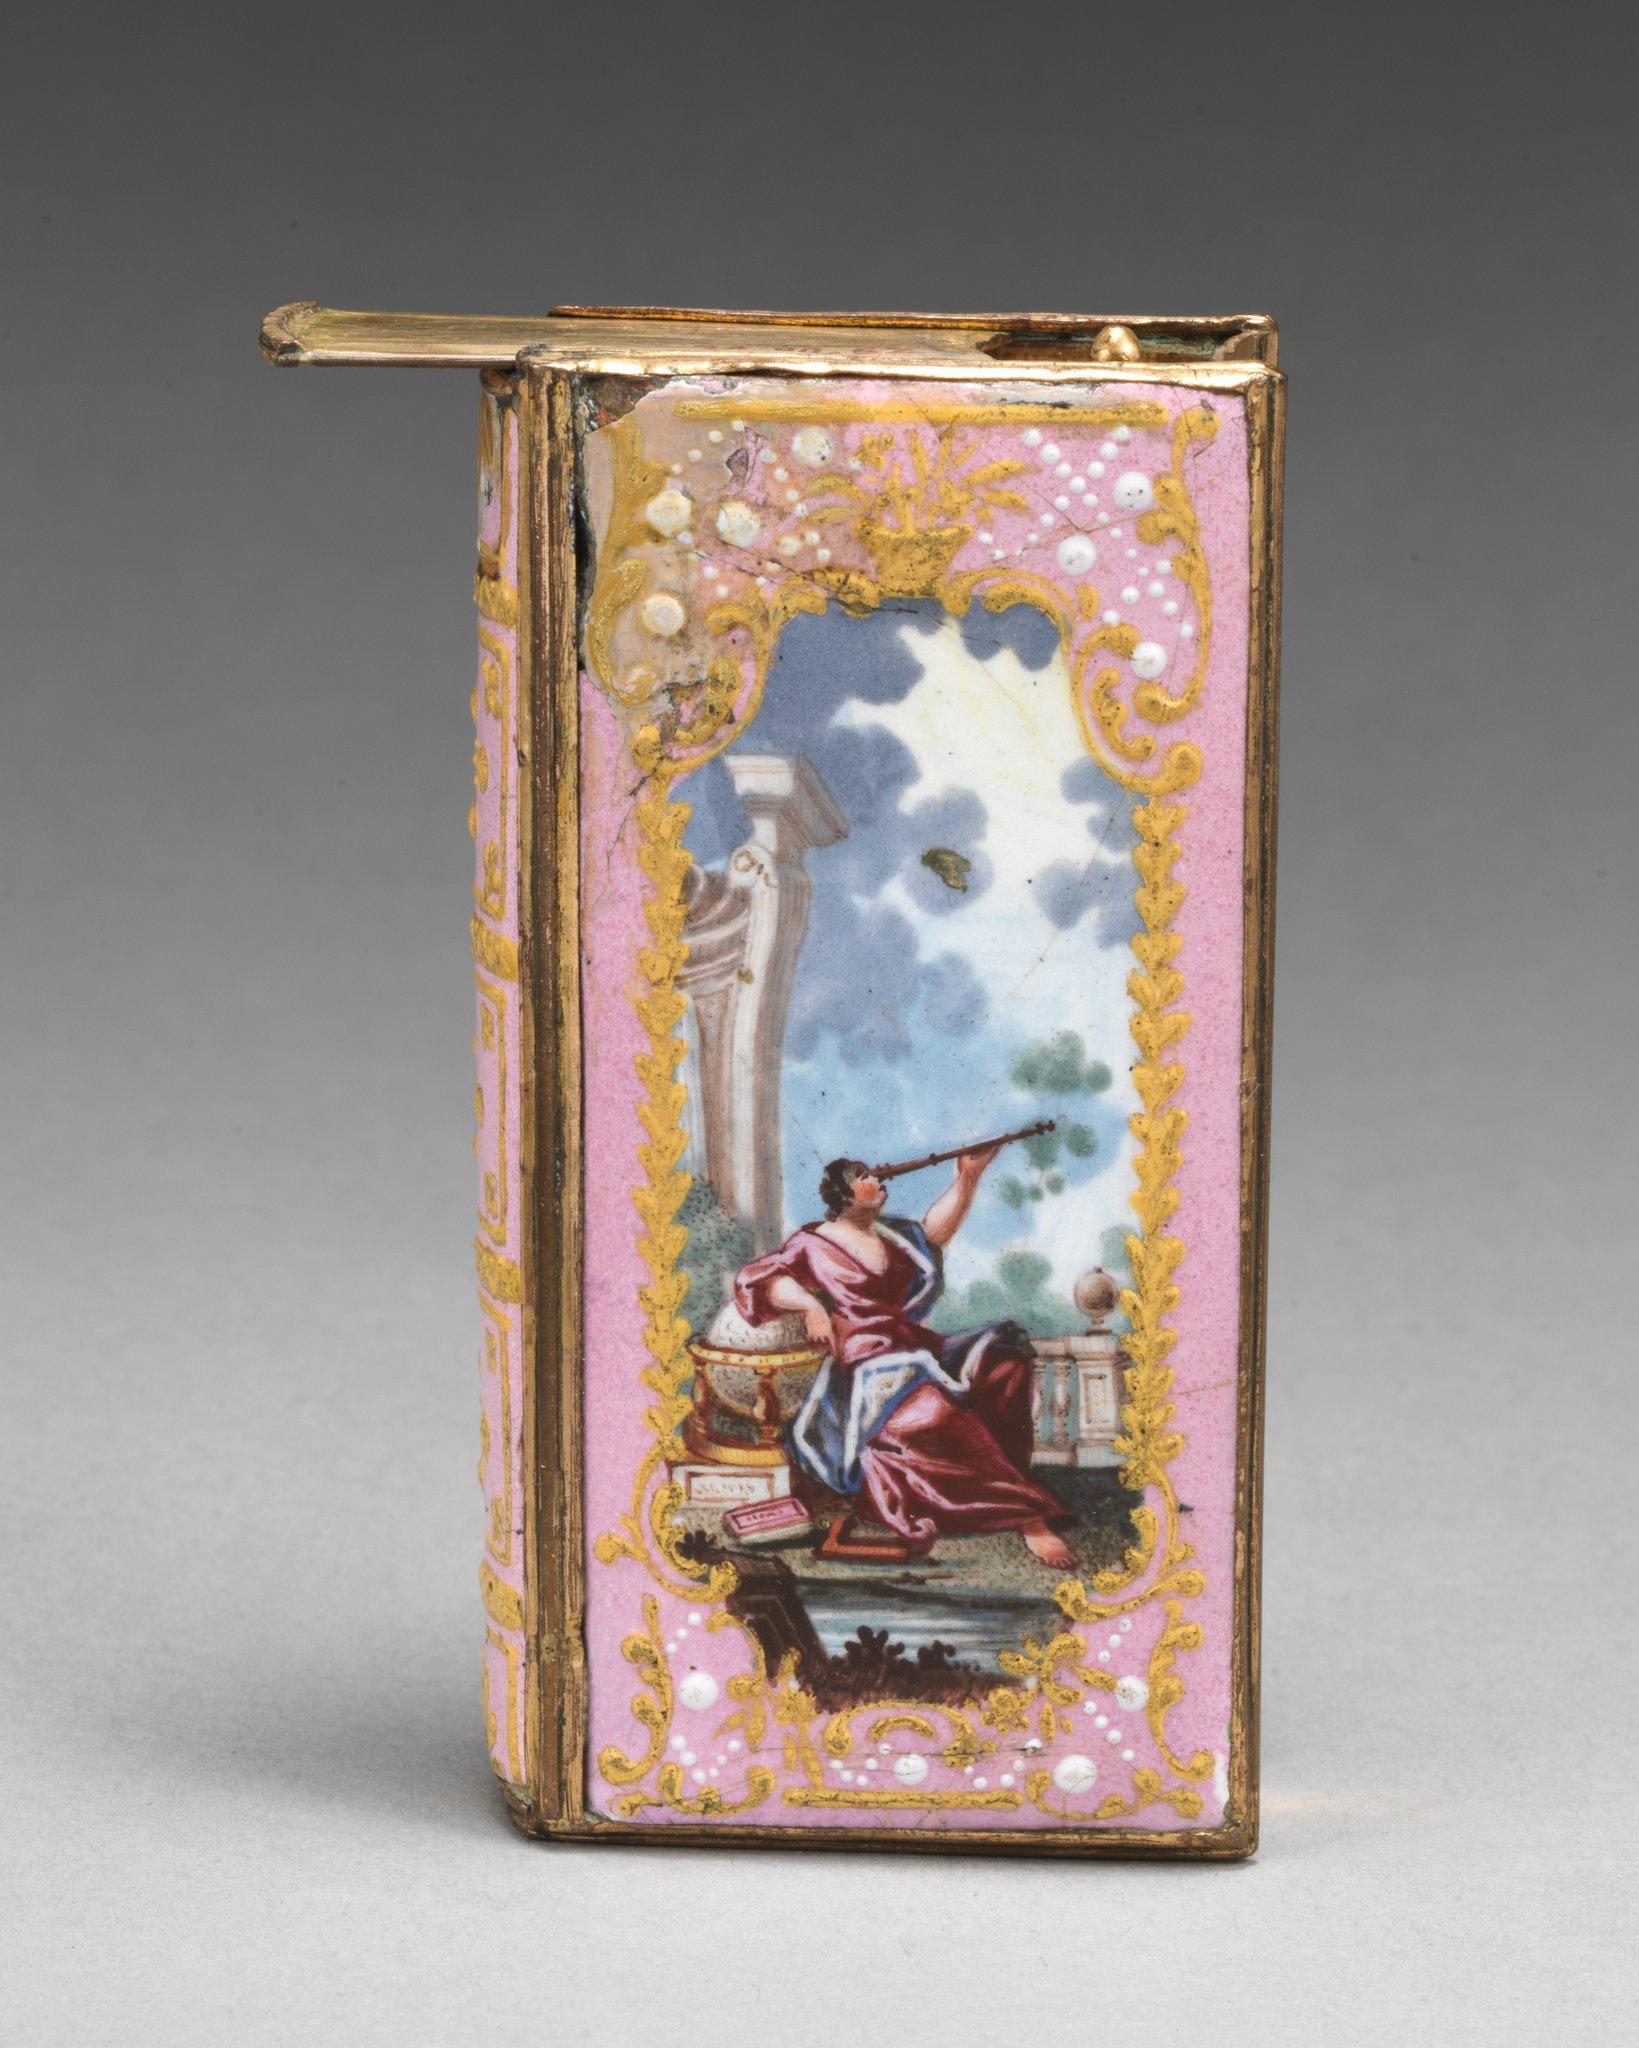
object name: nécessaire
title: Book-shaped nécessaire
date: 1765-1770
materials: copper gilt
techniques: enamel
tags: human figures,telescopes